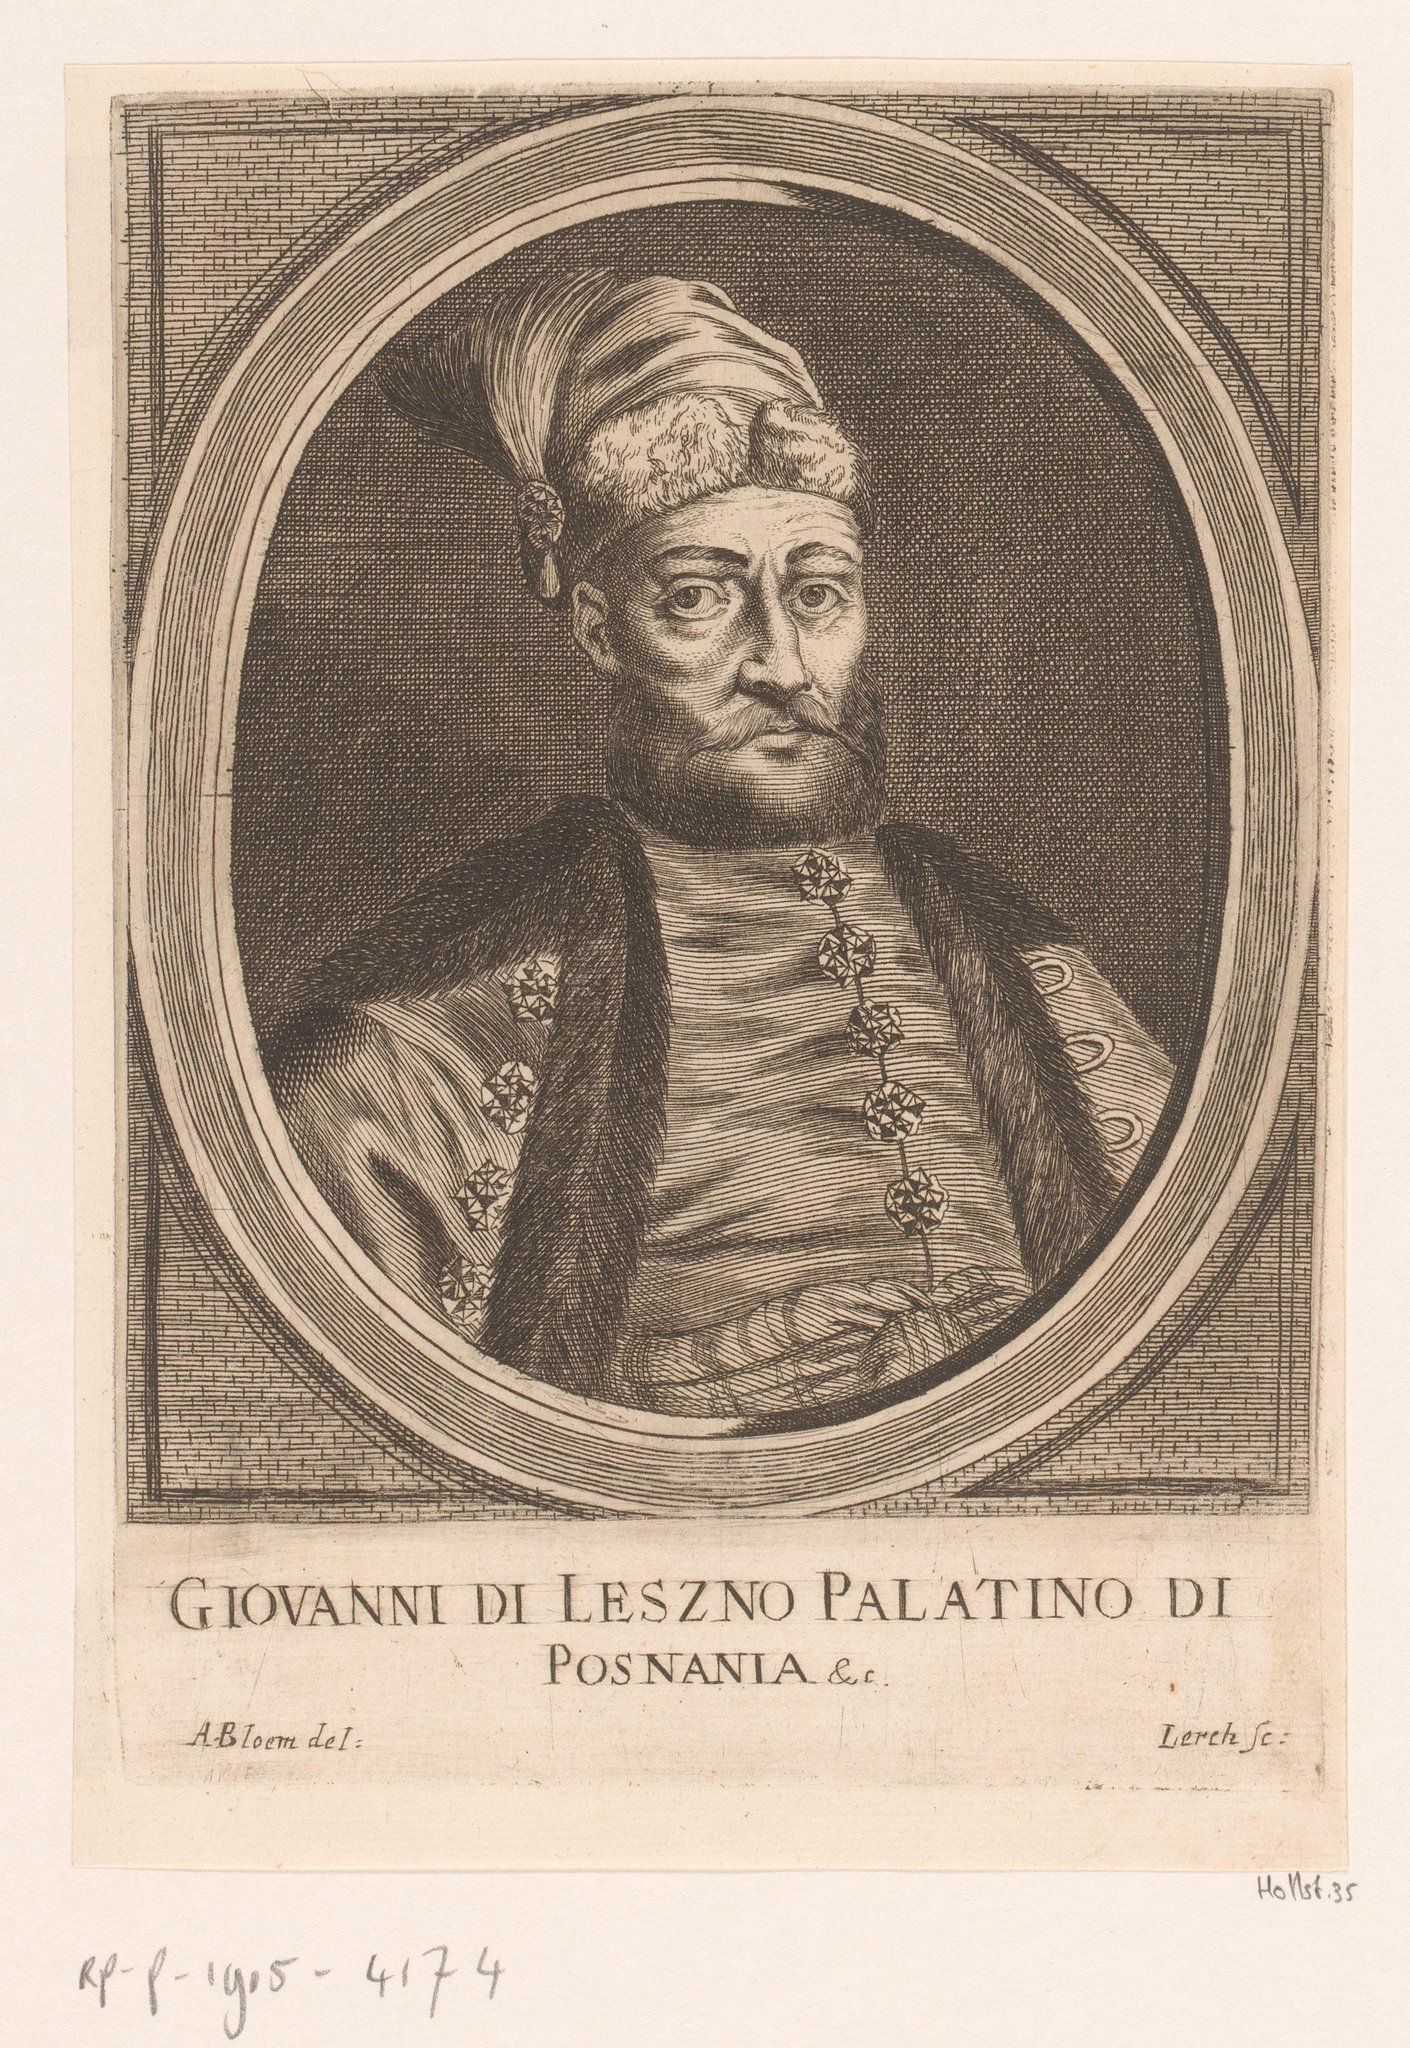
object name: print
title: Portret van Johann von Leszno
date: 1660-1685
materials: paper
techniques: engraving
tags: historical persons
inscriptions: collector's mark: Lugt 2228